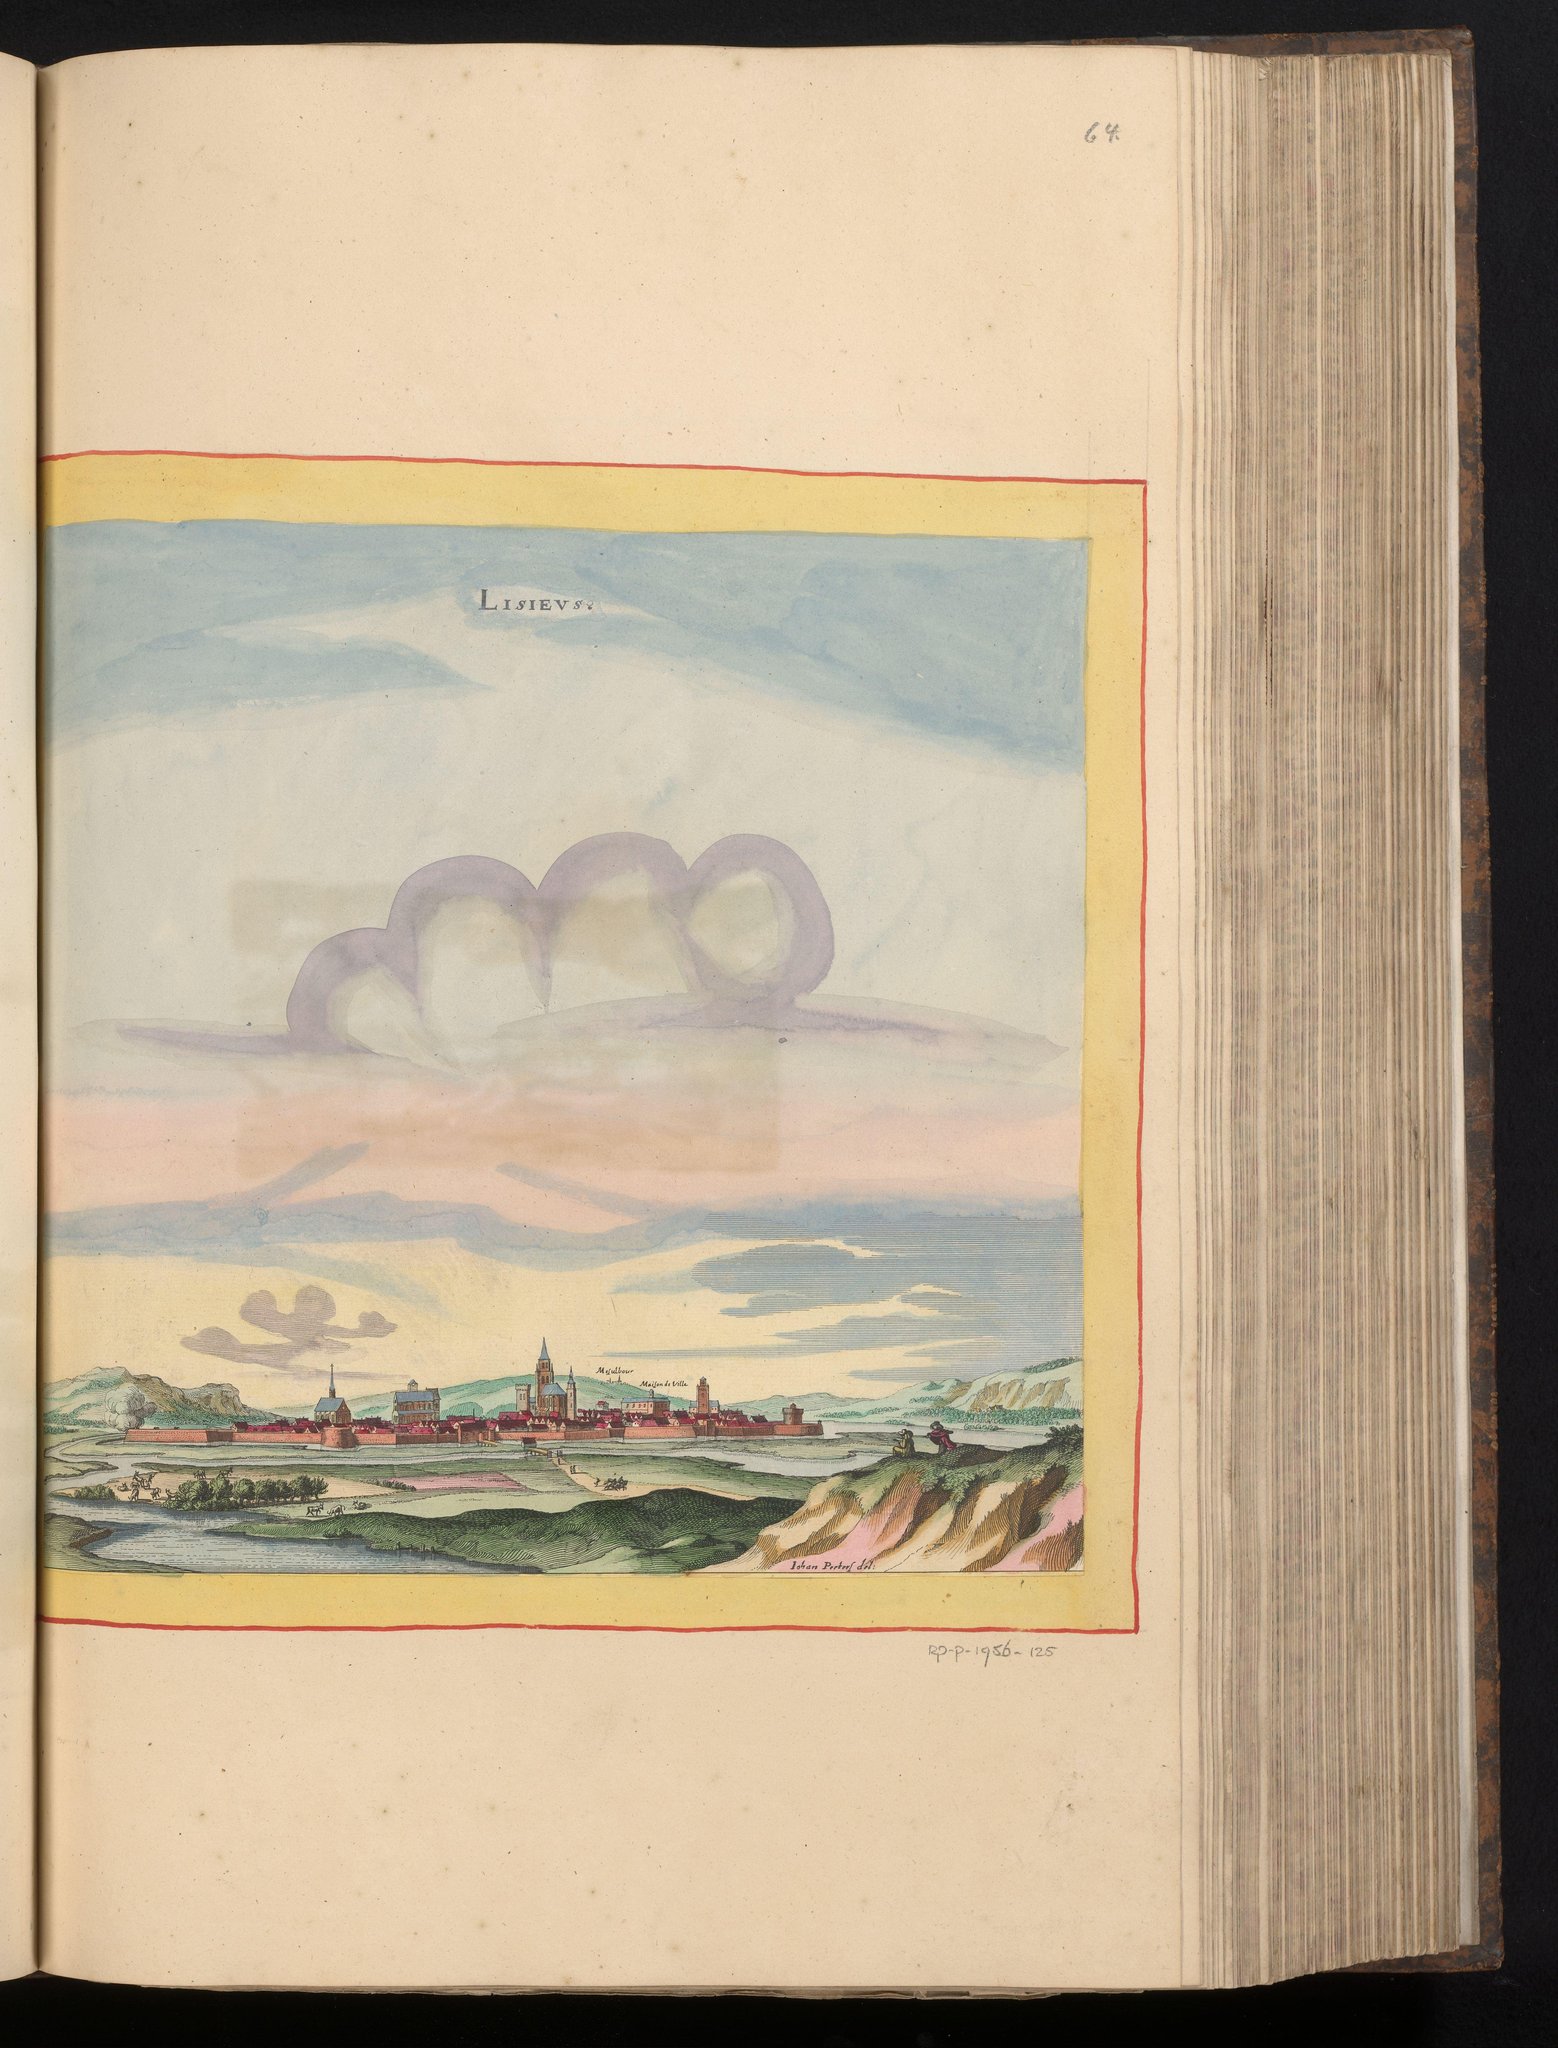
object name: album leaf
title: Gezicht op Lisieux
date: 1657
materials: paper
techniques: engraving, etching, hand coloring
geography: frankfurt am main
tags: village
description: Prent uit: Zeiller, Martin. Topographia Galliae. 13 dln. Frankfurt: Caspar Merian, 1657, dl. 8, na p. 20. De titel is uit de originele prent gesneden. Boven de gravure is een deel lucht en wolken (bij)geschilderd, waarin de titel gelijmd is. Origineel op één blad gedrukt met het gezicht op Mont Saint-Michel (RP-P-1956-127).